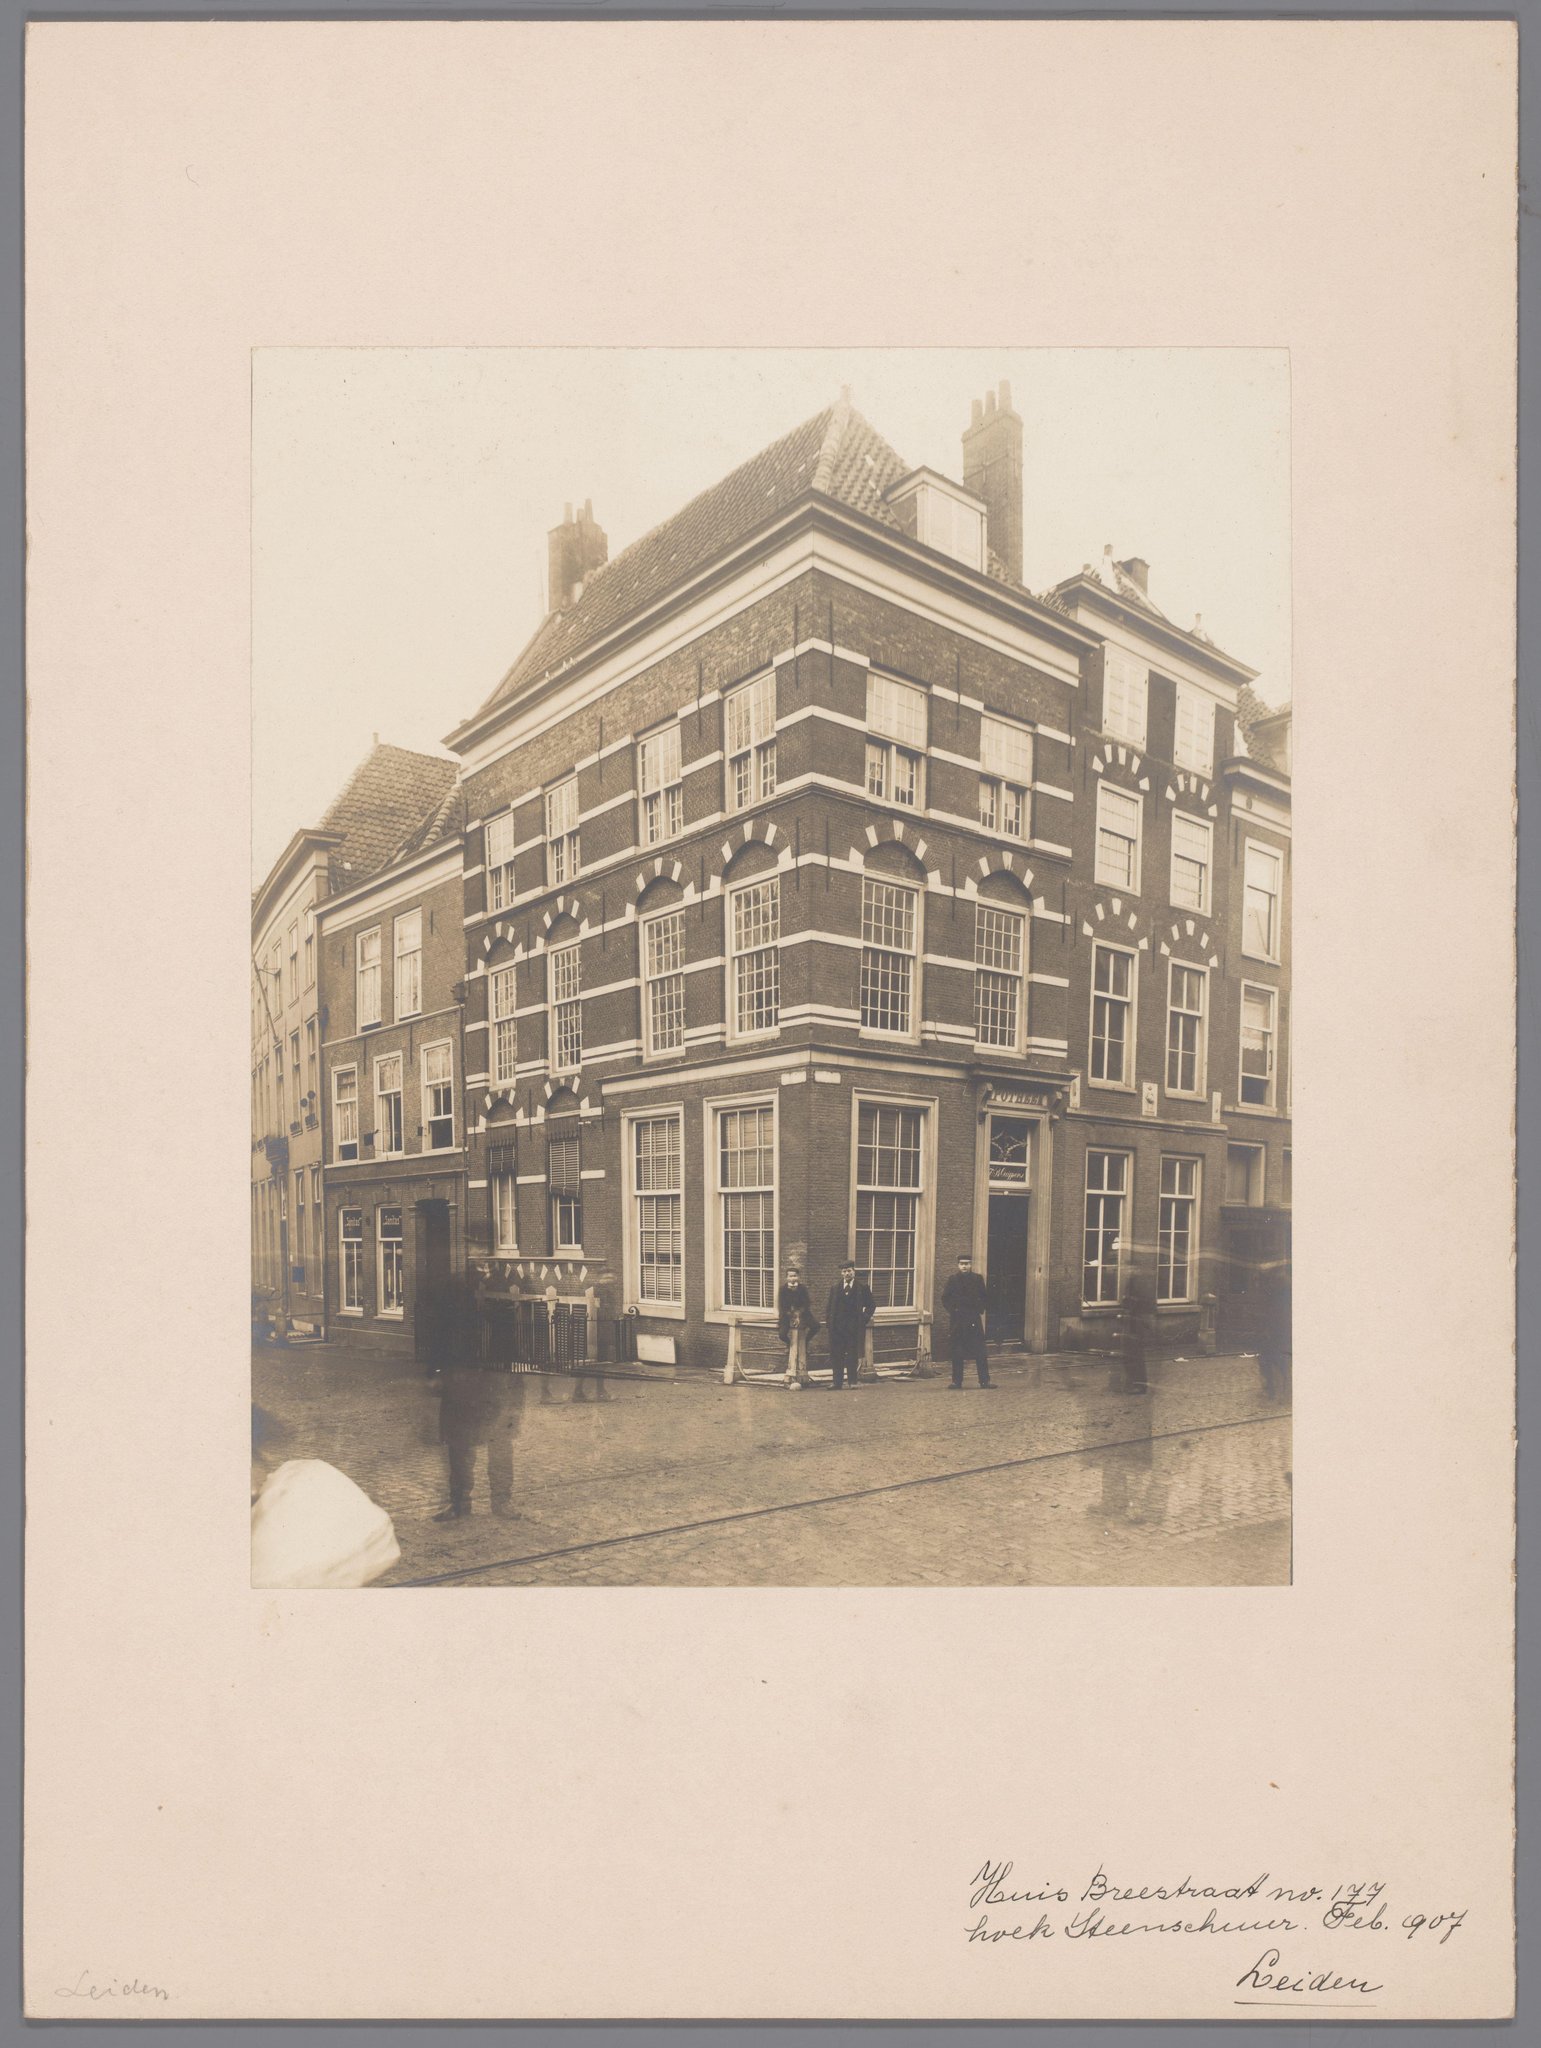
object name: photograph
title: Huis op Breestraat 177 te Leiden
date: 1907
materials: cardboard, photographic support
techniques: gelatin silver print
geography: breestraat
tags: façade (of house or building), public road (+ city(-scape) with figures, staffage)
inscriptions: collector's mark: ‘R:MUS.’ Lugt 2228, annotation: ‘Leiden II woonruimte’, annotation: ‘Leiden. Huis Breestraat No. 177/ hoek Steenschuur/ feb 1907’, annotation: ‘Huis Breestraat no. 177/ hoek Steenschuur. Feb. 1907/ Leiden’